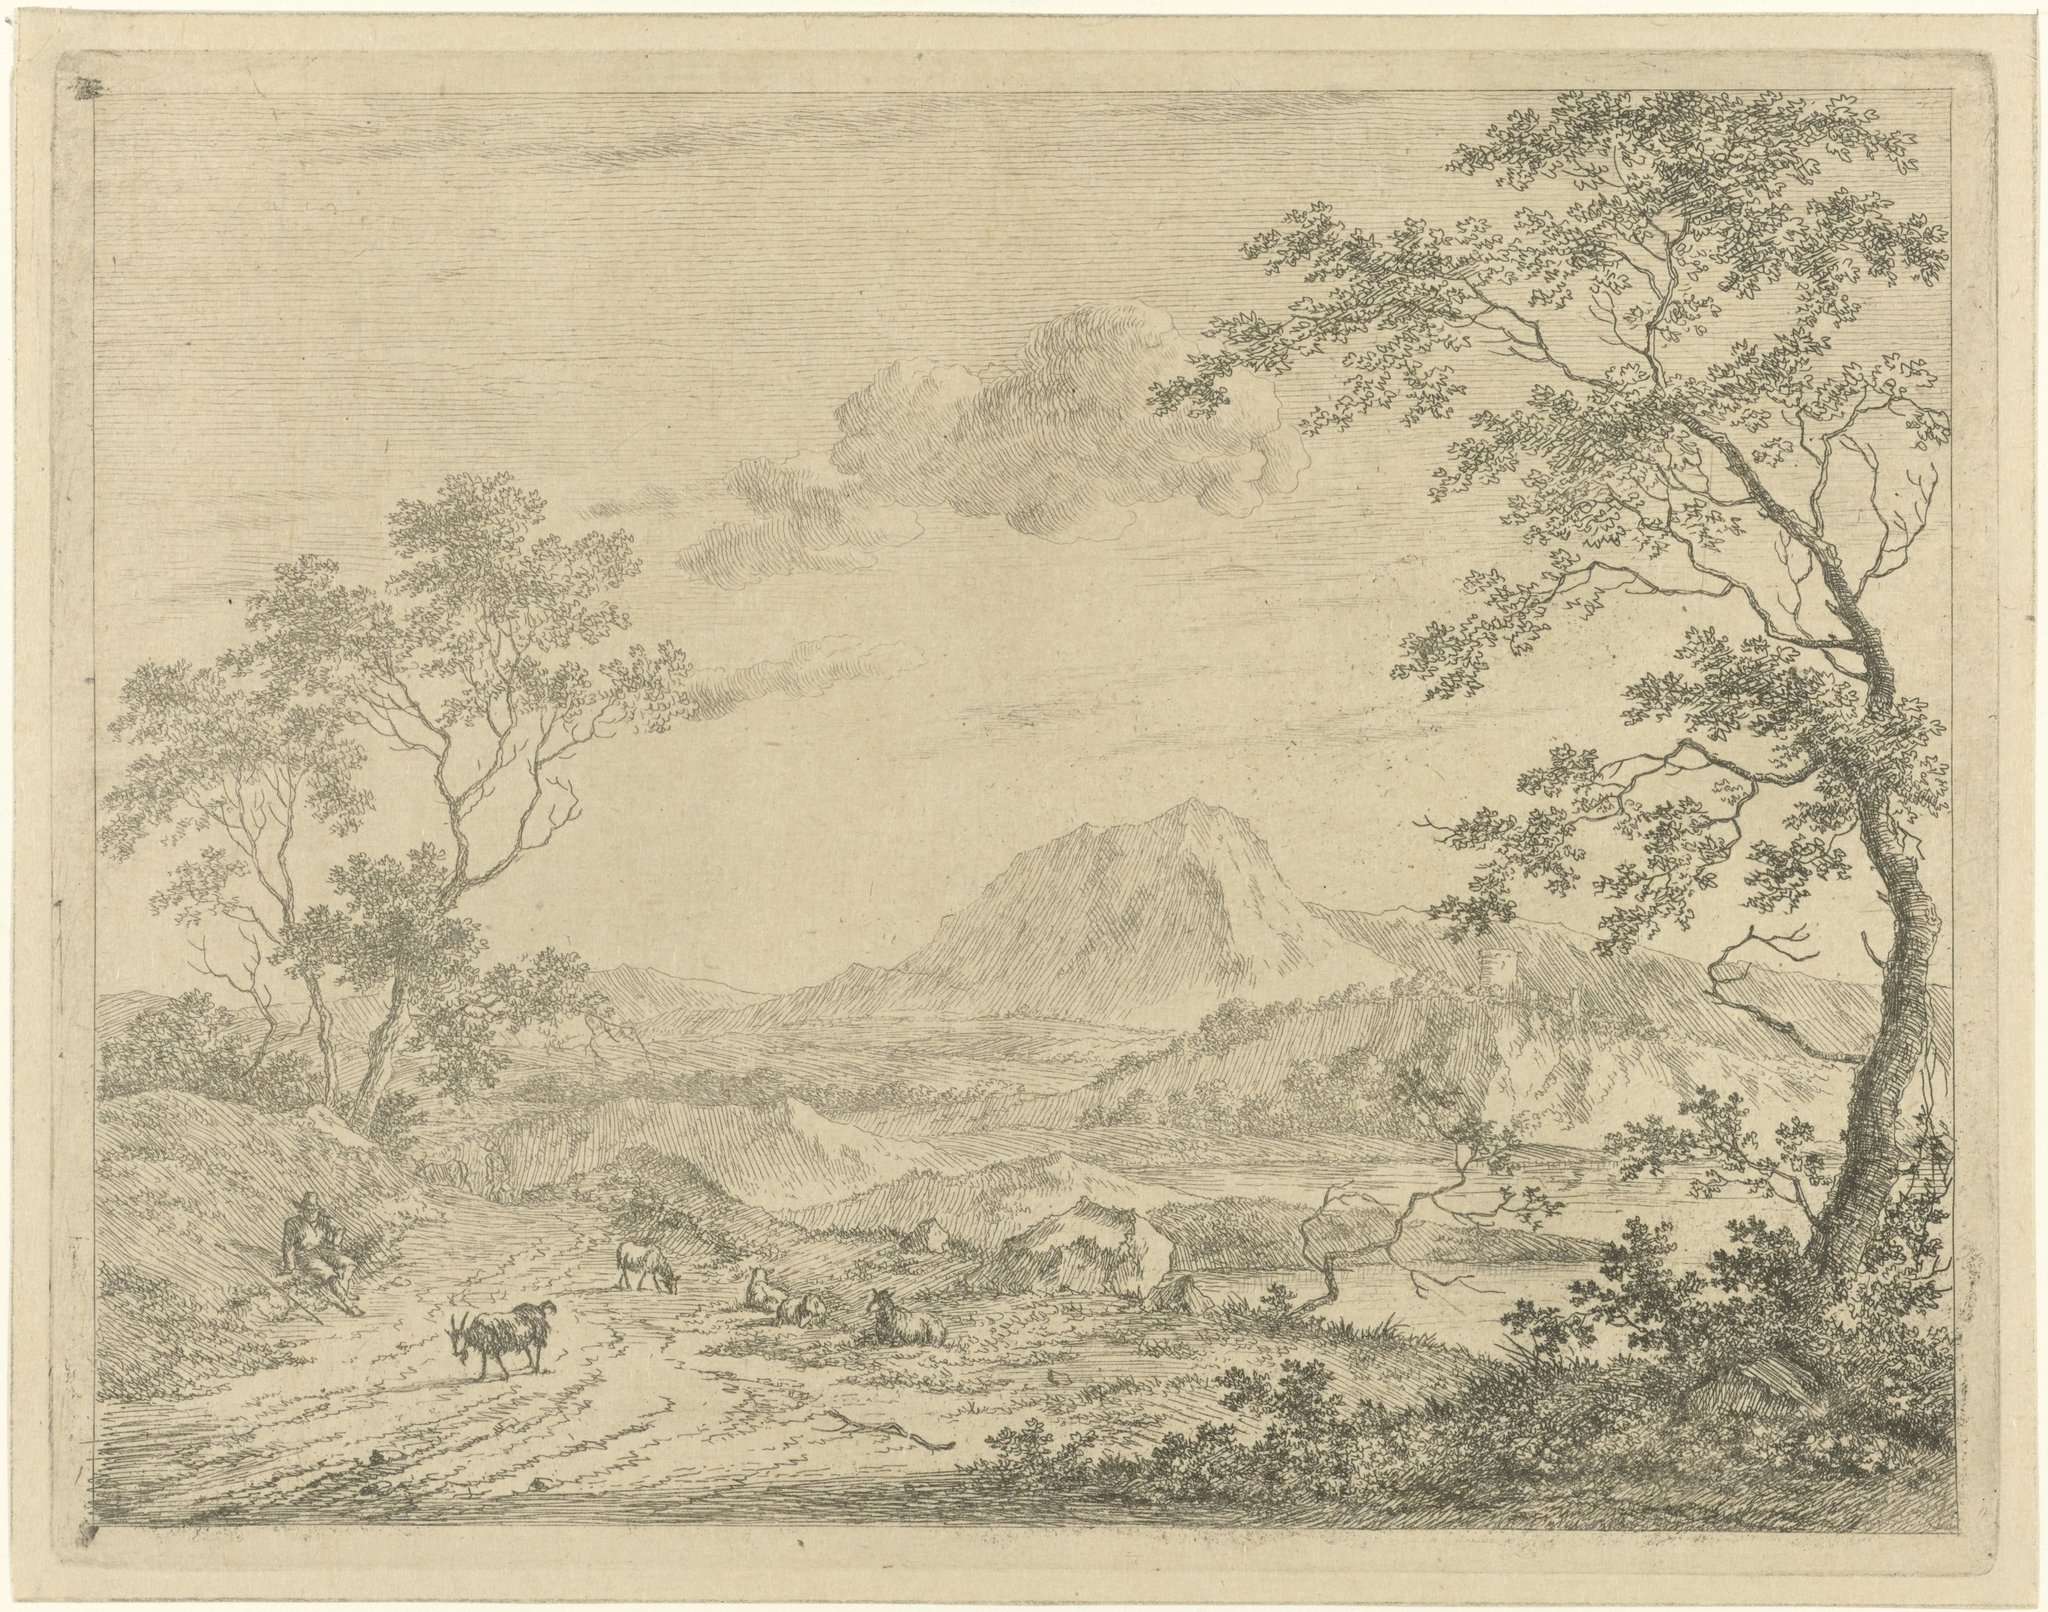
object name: print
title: Bergachtig landschap met rustende herder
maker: johannes janson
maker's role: draughtsman, painter, print maker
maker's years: 1729-1784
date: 1761-1784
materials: paper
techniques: etching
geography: leiden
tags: landscapes (+ landscape with figures, staffage)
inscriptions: collector's mark: Lugt 240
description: Bergachtig landschap met links een rustende herder met schapen en een bok. Rechts een meer. Prent uit een serie met landschappen met herders en vee.